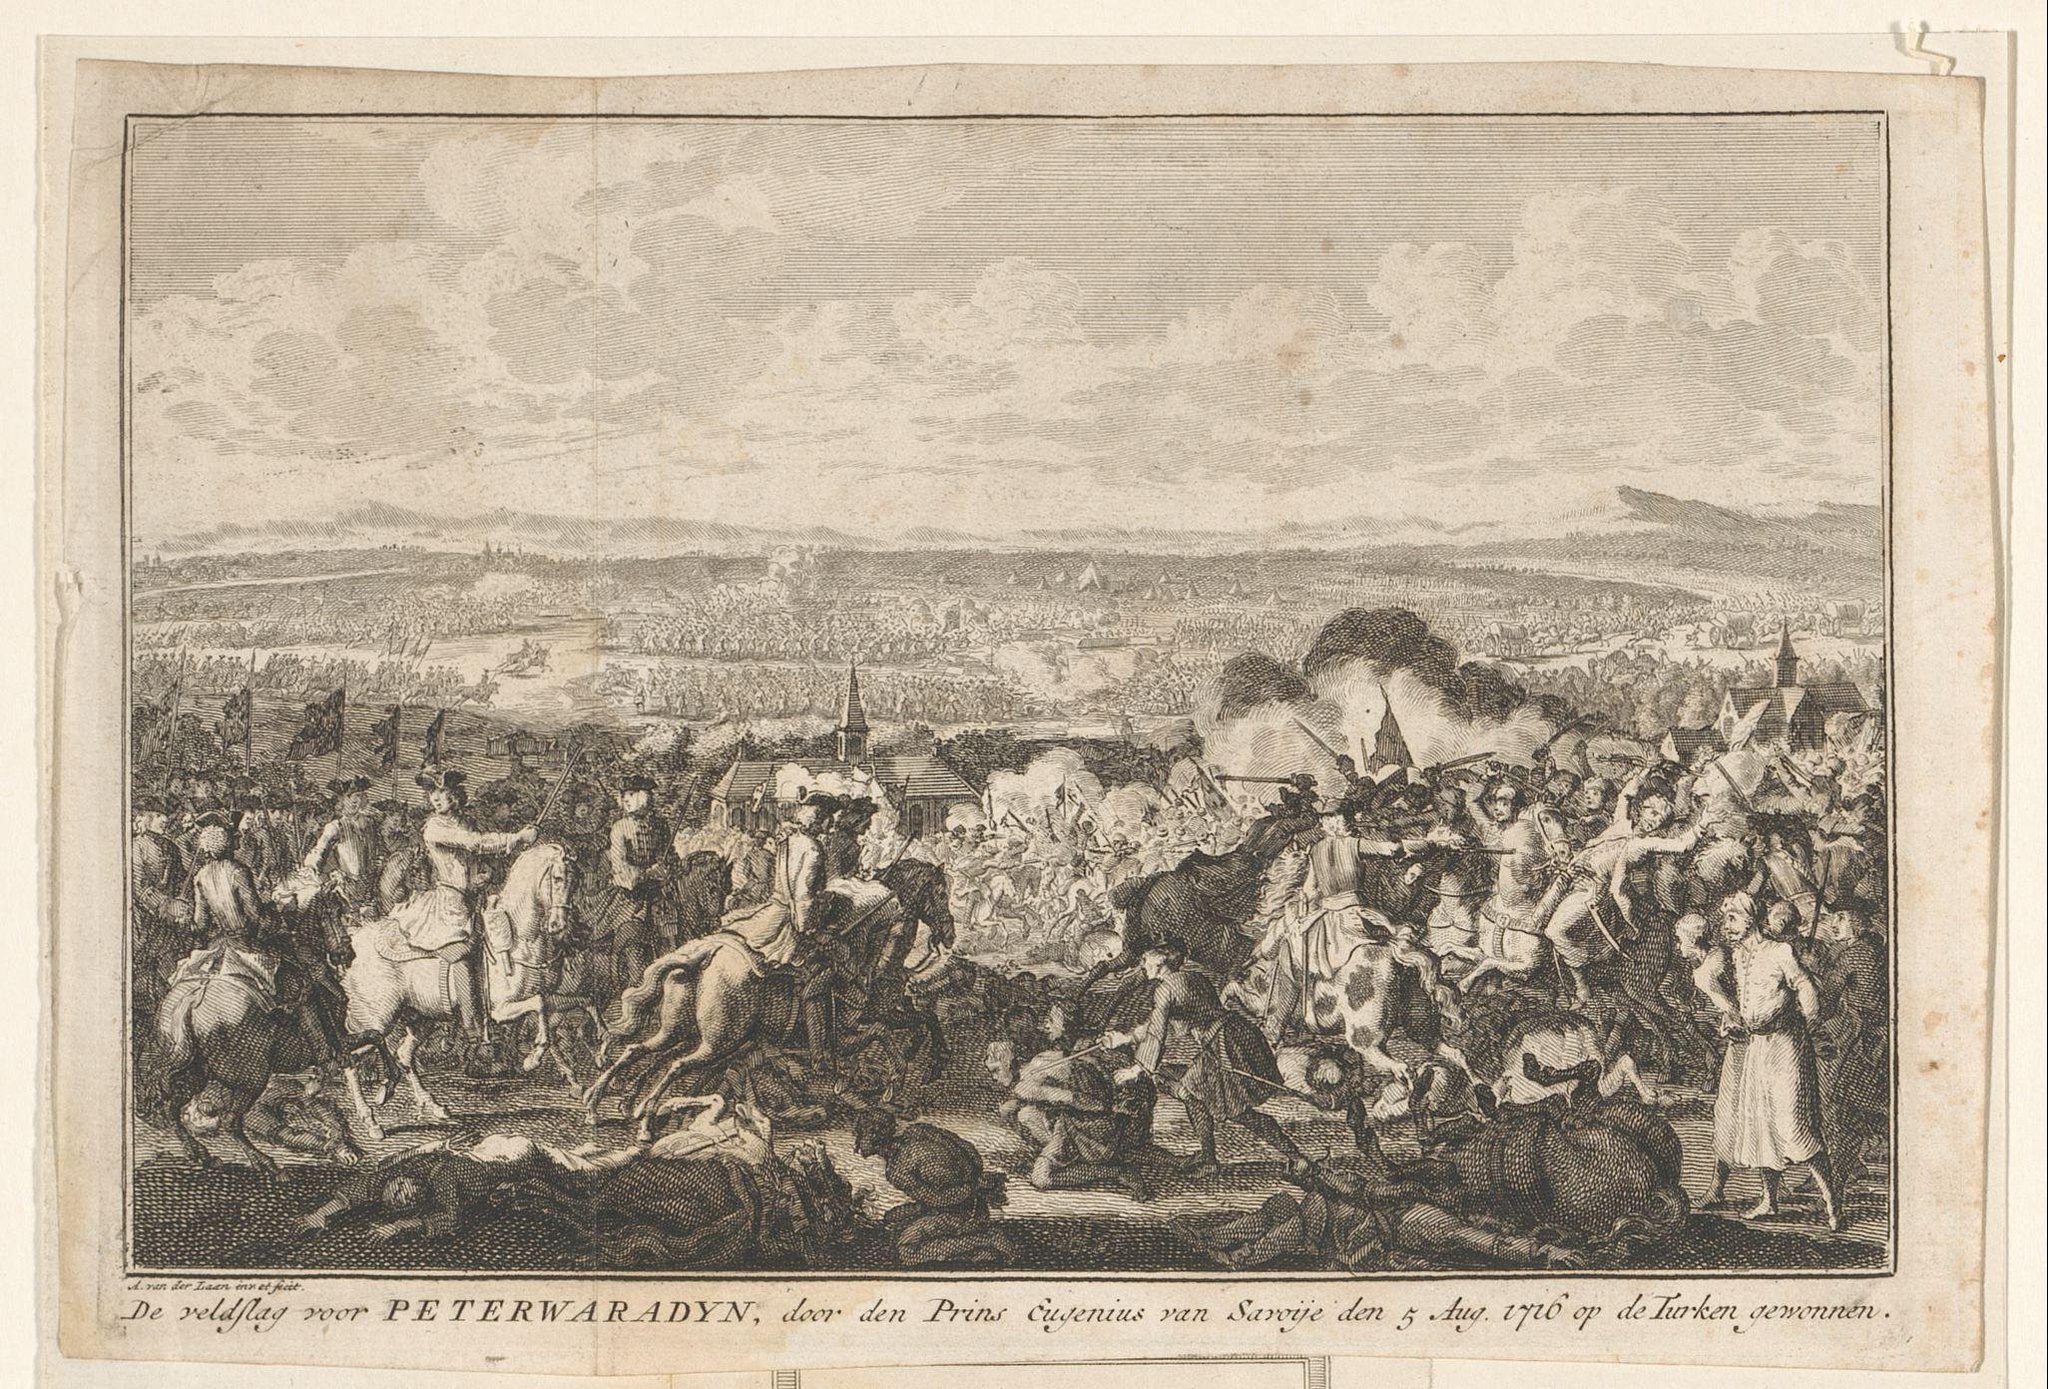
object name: print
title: Slag bij Petrovaradin, 1716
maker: adolf van der laan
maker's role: draughtsman, print maker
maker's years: 1689-1742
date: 1716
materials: paper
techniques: engraving, etching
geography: netherlands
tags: paris, vienna, eugenius van savoye, battle (+ land forces)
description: De slag bij Petrovaradin (het huidige Novi Sad in Servië) aan de Donau met een overwinning van de keizerlijke troepen onder de prins van Savoye op de Turken, 5 augustus 1716. Op een opzetblad samen met het portret van Eugenius van Savoye.